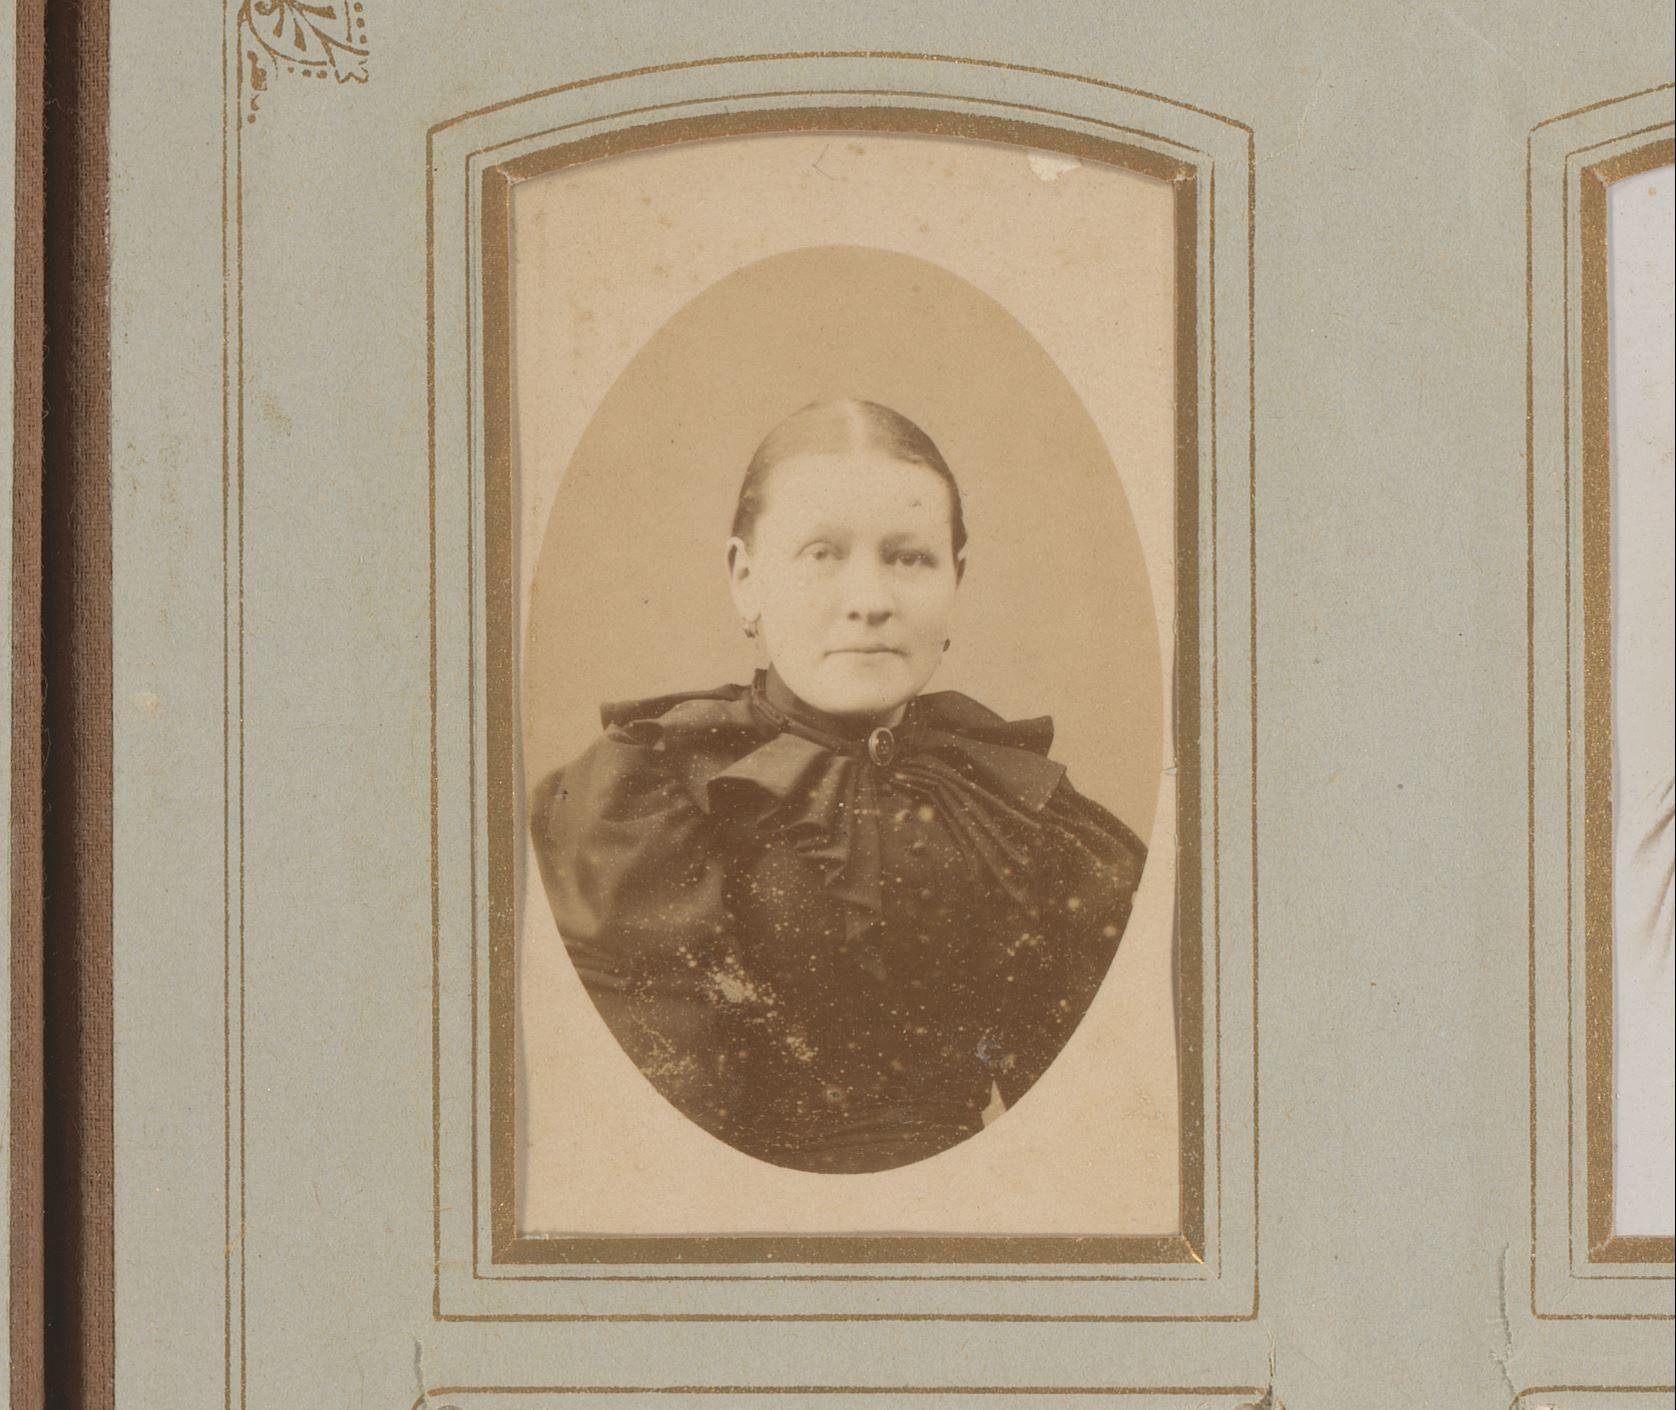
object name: album leaf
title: Portret van een vrouw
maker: pieter siewers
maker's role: fotograaf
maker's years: 1819-1898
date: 1857-1898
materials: cardboard, photographic support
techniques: albumen print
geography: edam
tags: historical persons - bb - woman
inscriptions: inscription: ‘P. SIEUWERS,/ Photograaf,/ Voorhaven b/d R. K. Kerk,/ EDAM.’